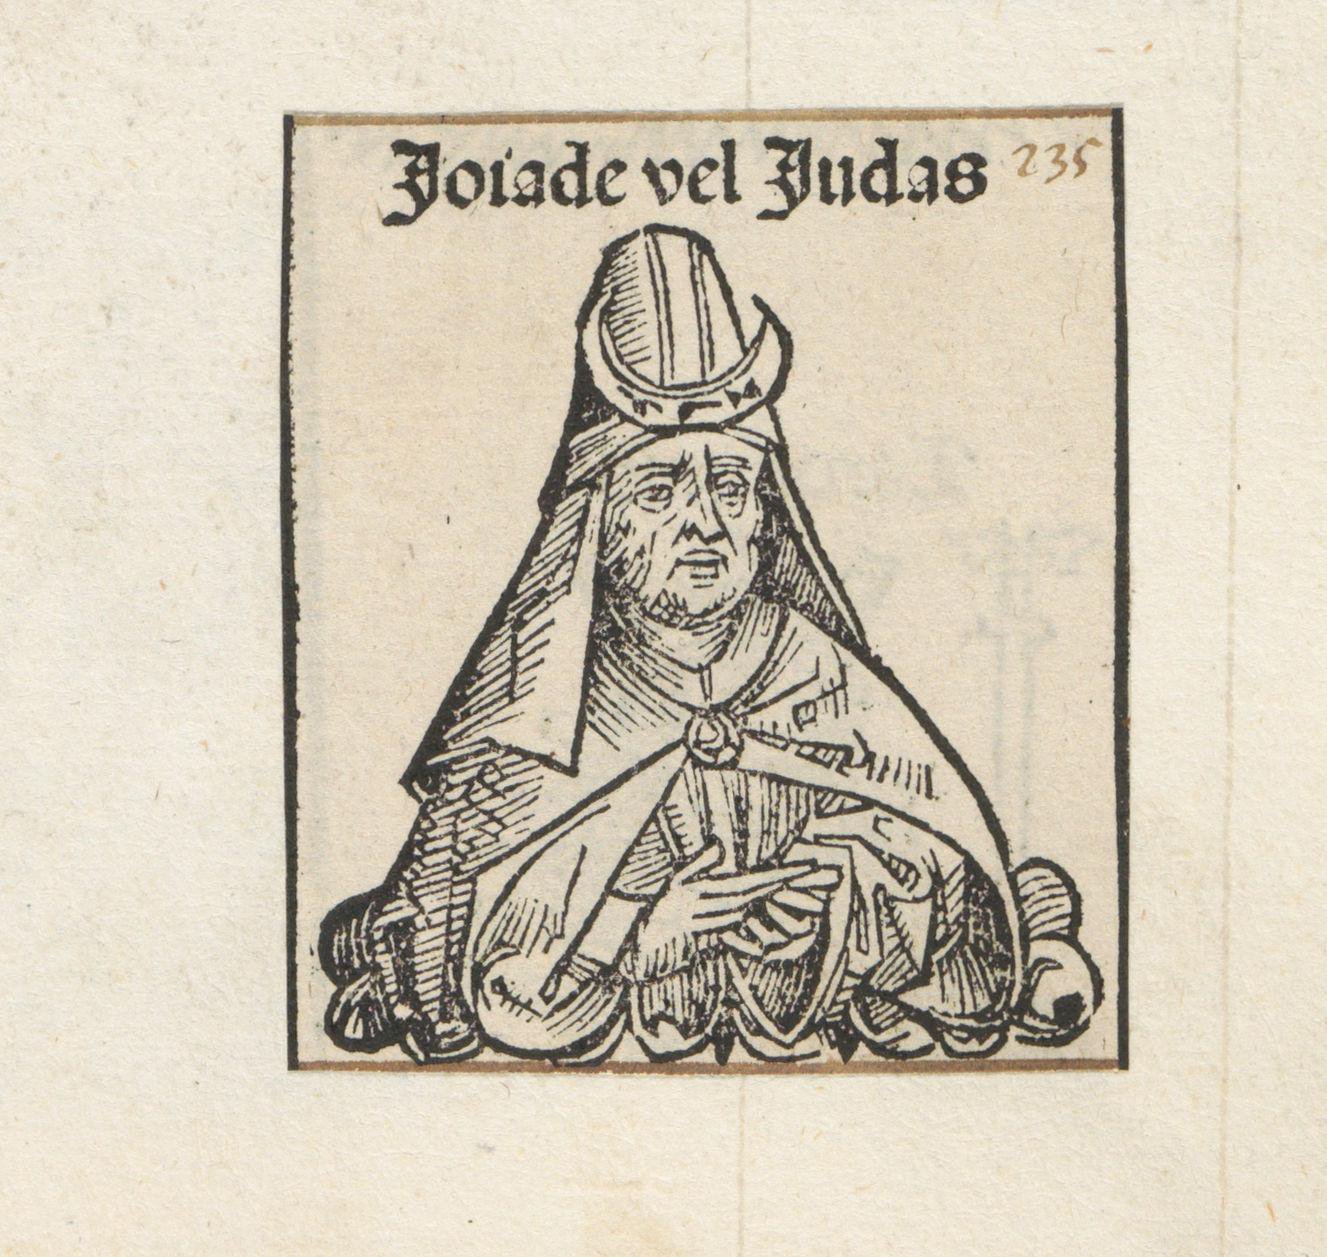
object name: book illustration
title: Jojada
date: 1493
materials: paper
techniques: letterpress printing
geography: nuremberg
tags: high priest ~ hierarchy of priests, persons from the old testament (not in biblical context, nor occurring in legendary/historical extensions included in division 71)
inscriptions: inscription: ‘235’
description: Een bloemkelk met een man in priesterkledij, naar voren gericht. De tekst identificeert hem als Jojada, hogepriester en zoon van Eljasib. De voorstelling is onderdeel van de opeenvolging priesters in de Liber Chronicarum. De prent maakt deel uit van een album.